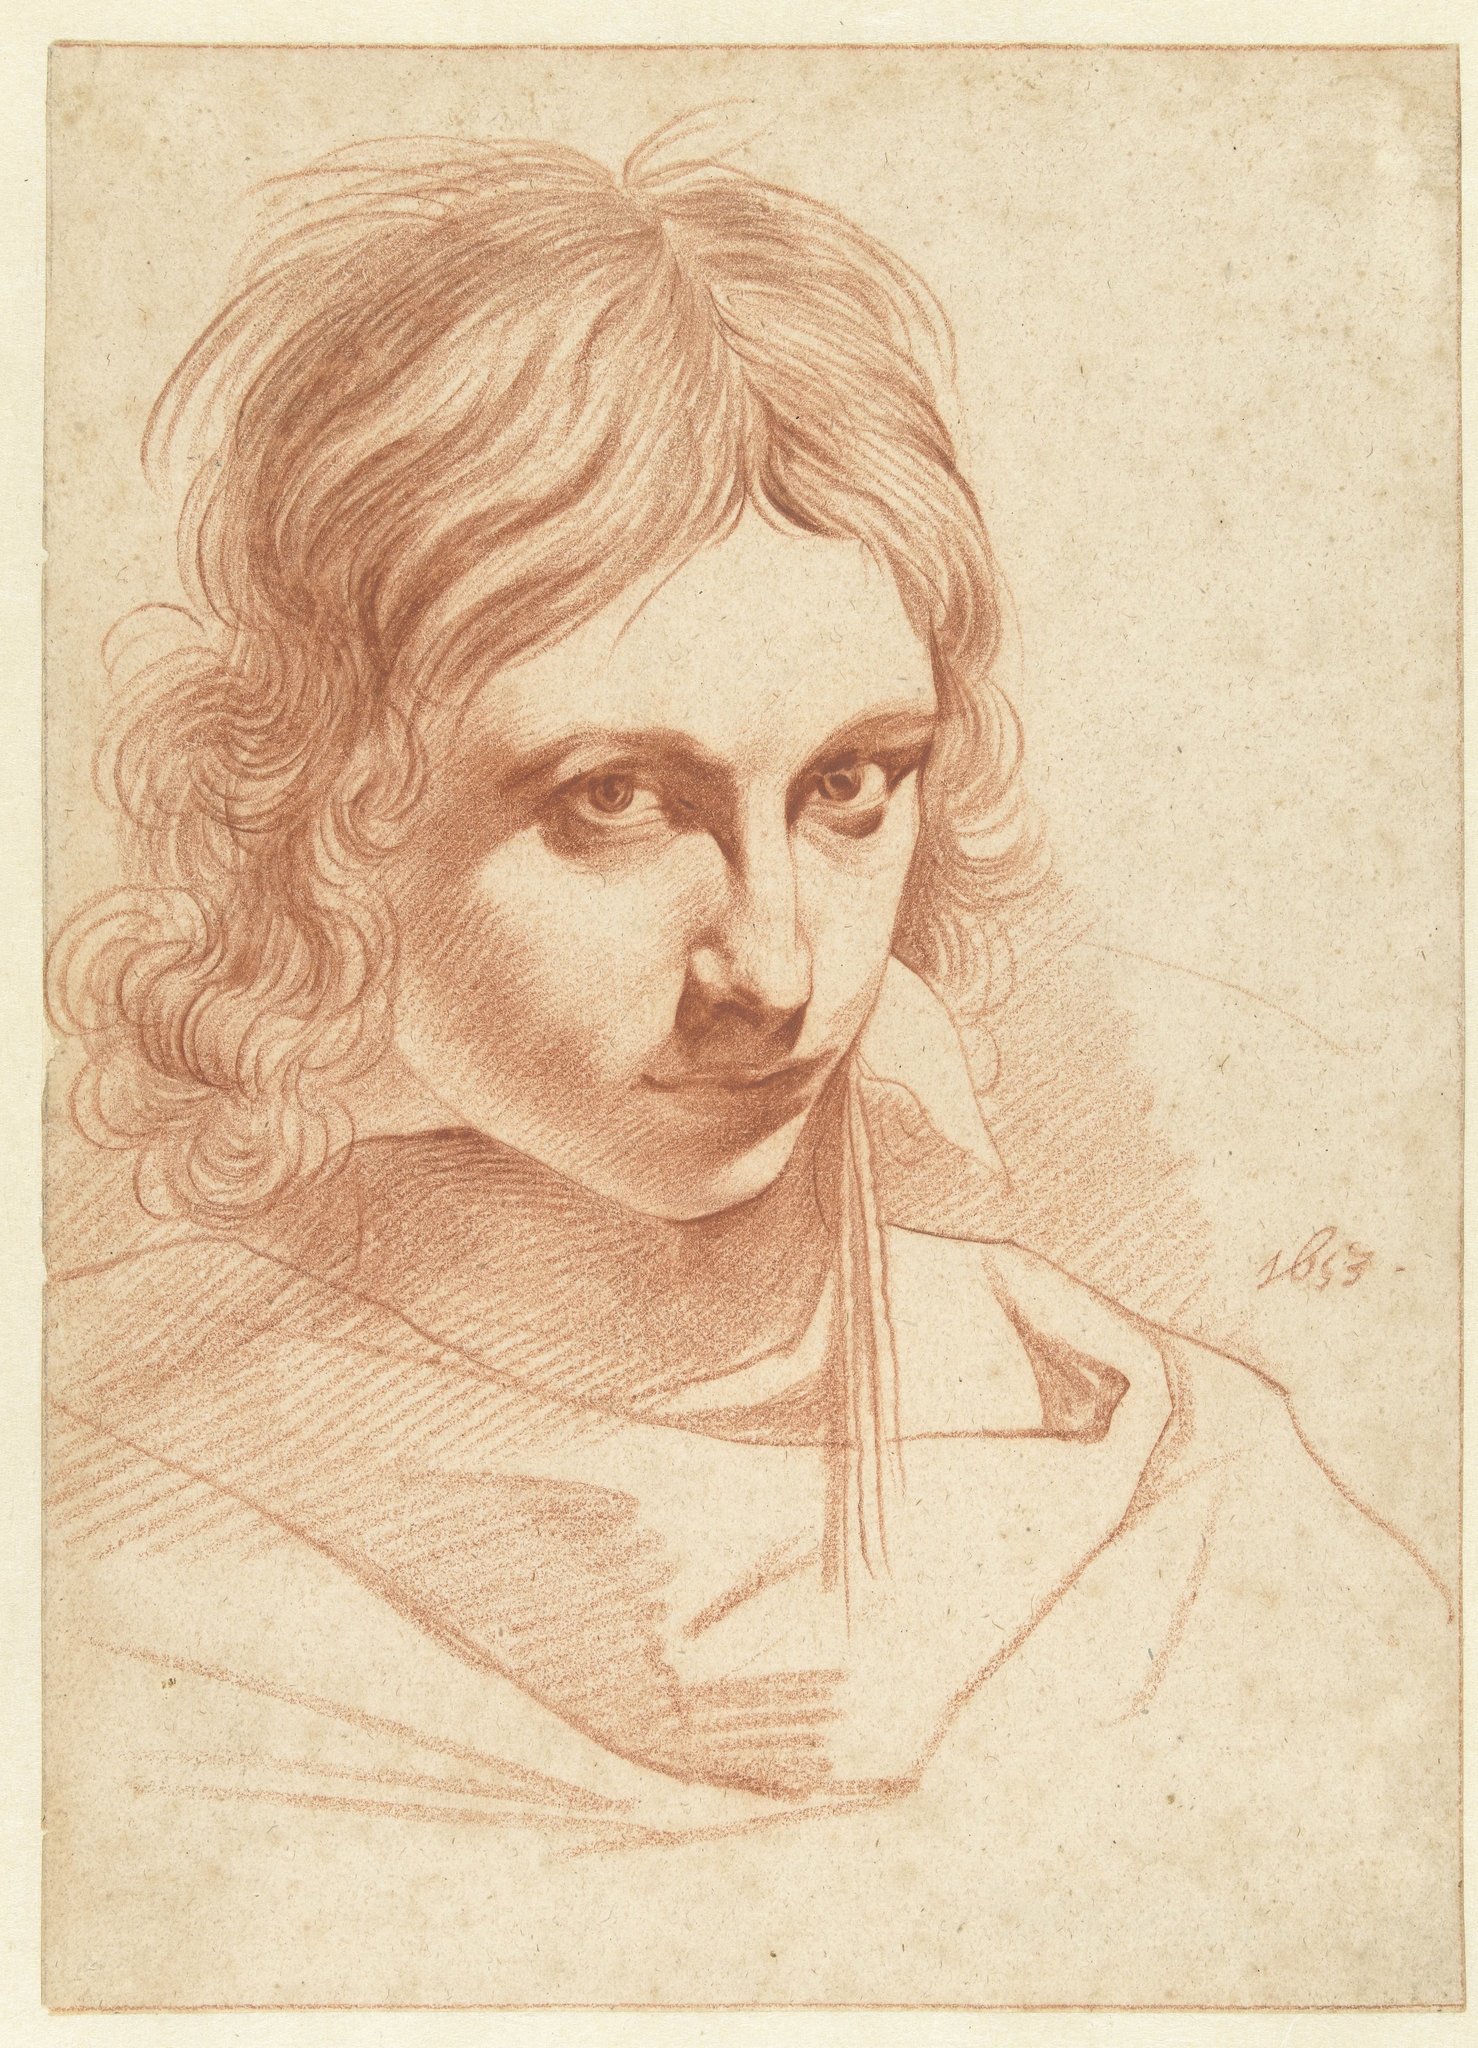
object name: drawing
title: Zelfportret van Leendert van der Cooghen (?)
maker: leendert van der cooghen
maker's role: draughtsman, print maker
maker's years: 1632-1681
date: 1653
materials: chalk, paper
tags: print maker, draughtsman, leendert van der cooghen, historical persons, portrait, self-portrait of draughtsman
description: Van der Cooghen behoorde tot een groep Haarlemse kunstenaars, die samen naar het leven tekenden en naast zelfportretten ook portretten van elkaar maakten. Hij was hoofdzakelijk tekenaar van figuren, koppen portretten. Zijn tekenstijl is beinvloed door Vlaamse kunstenaars als Rubens en Jordaens, van welke laatste hij een leerling was.